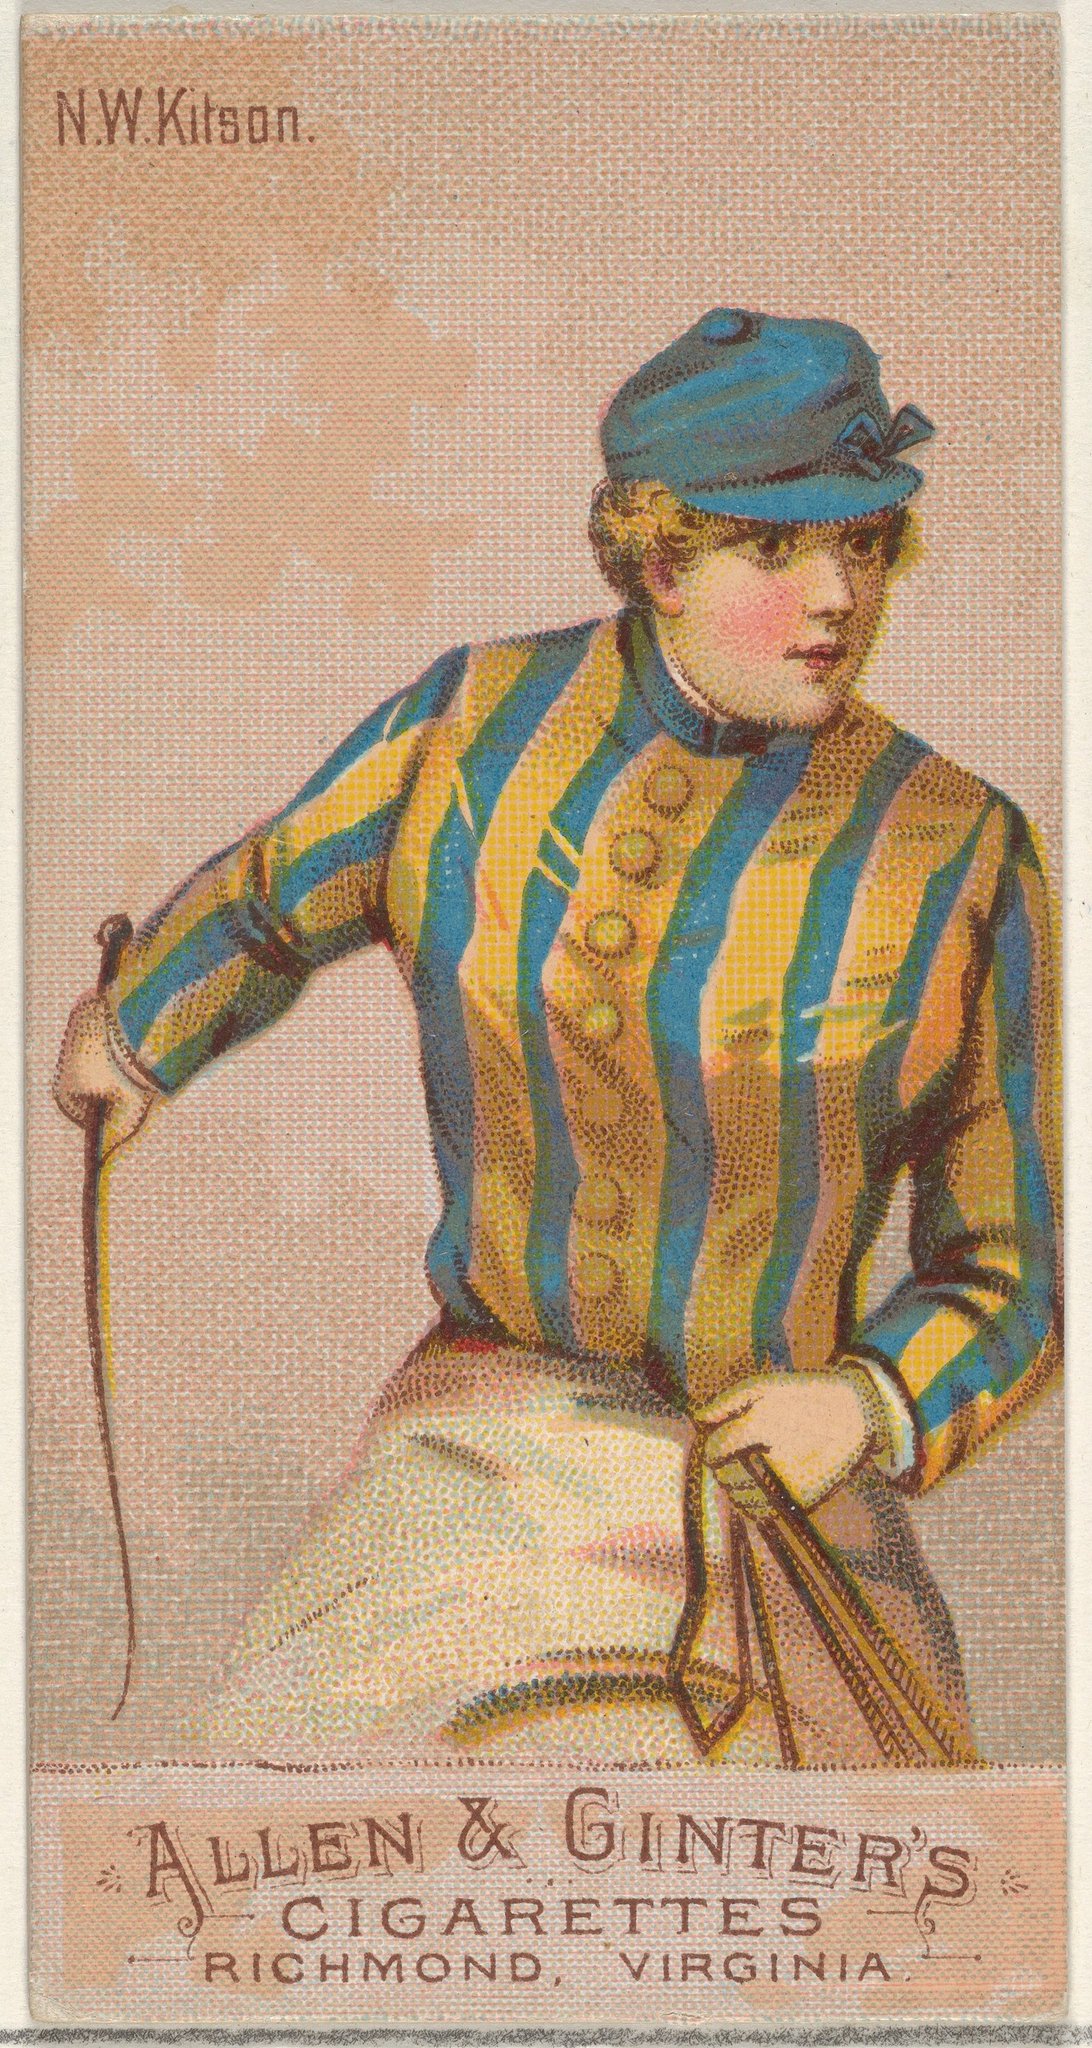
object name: print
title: N.W. Kitson, from the Racing Colors of the World series (N22b) for Allen & Ginter Cigarettes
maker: allen & ginter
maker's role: publisher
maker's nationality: american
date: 1888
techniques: color lithograph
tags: women,jockeys